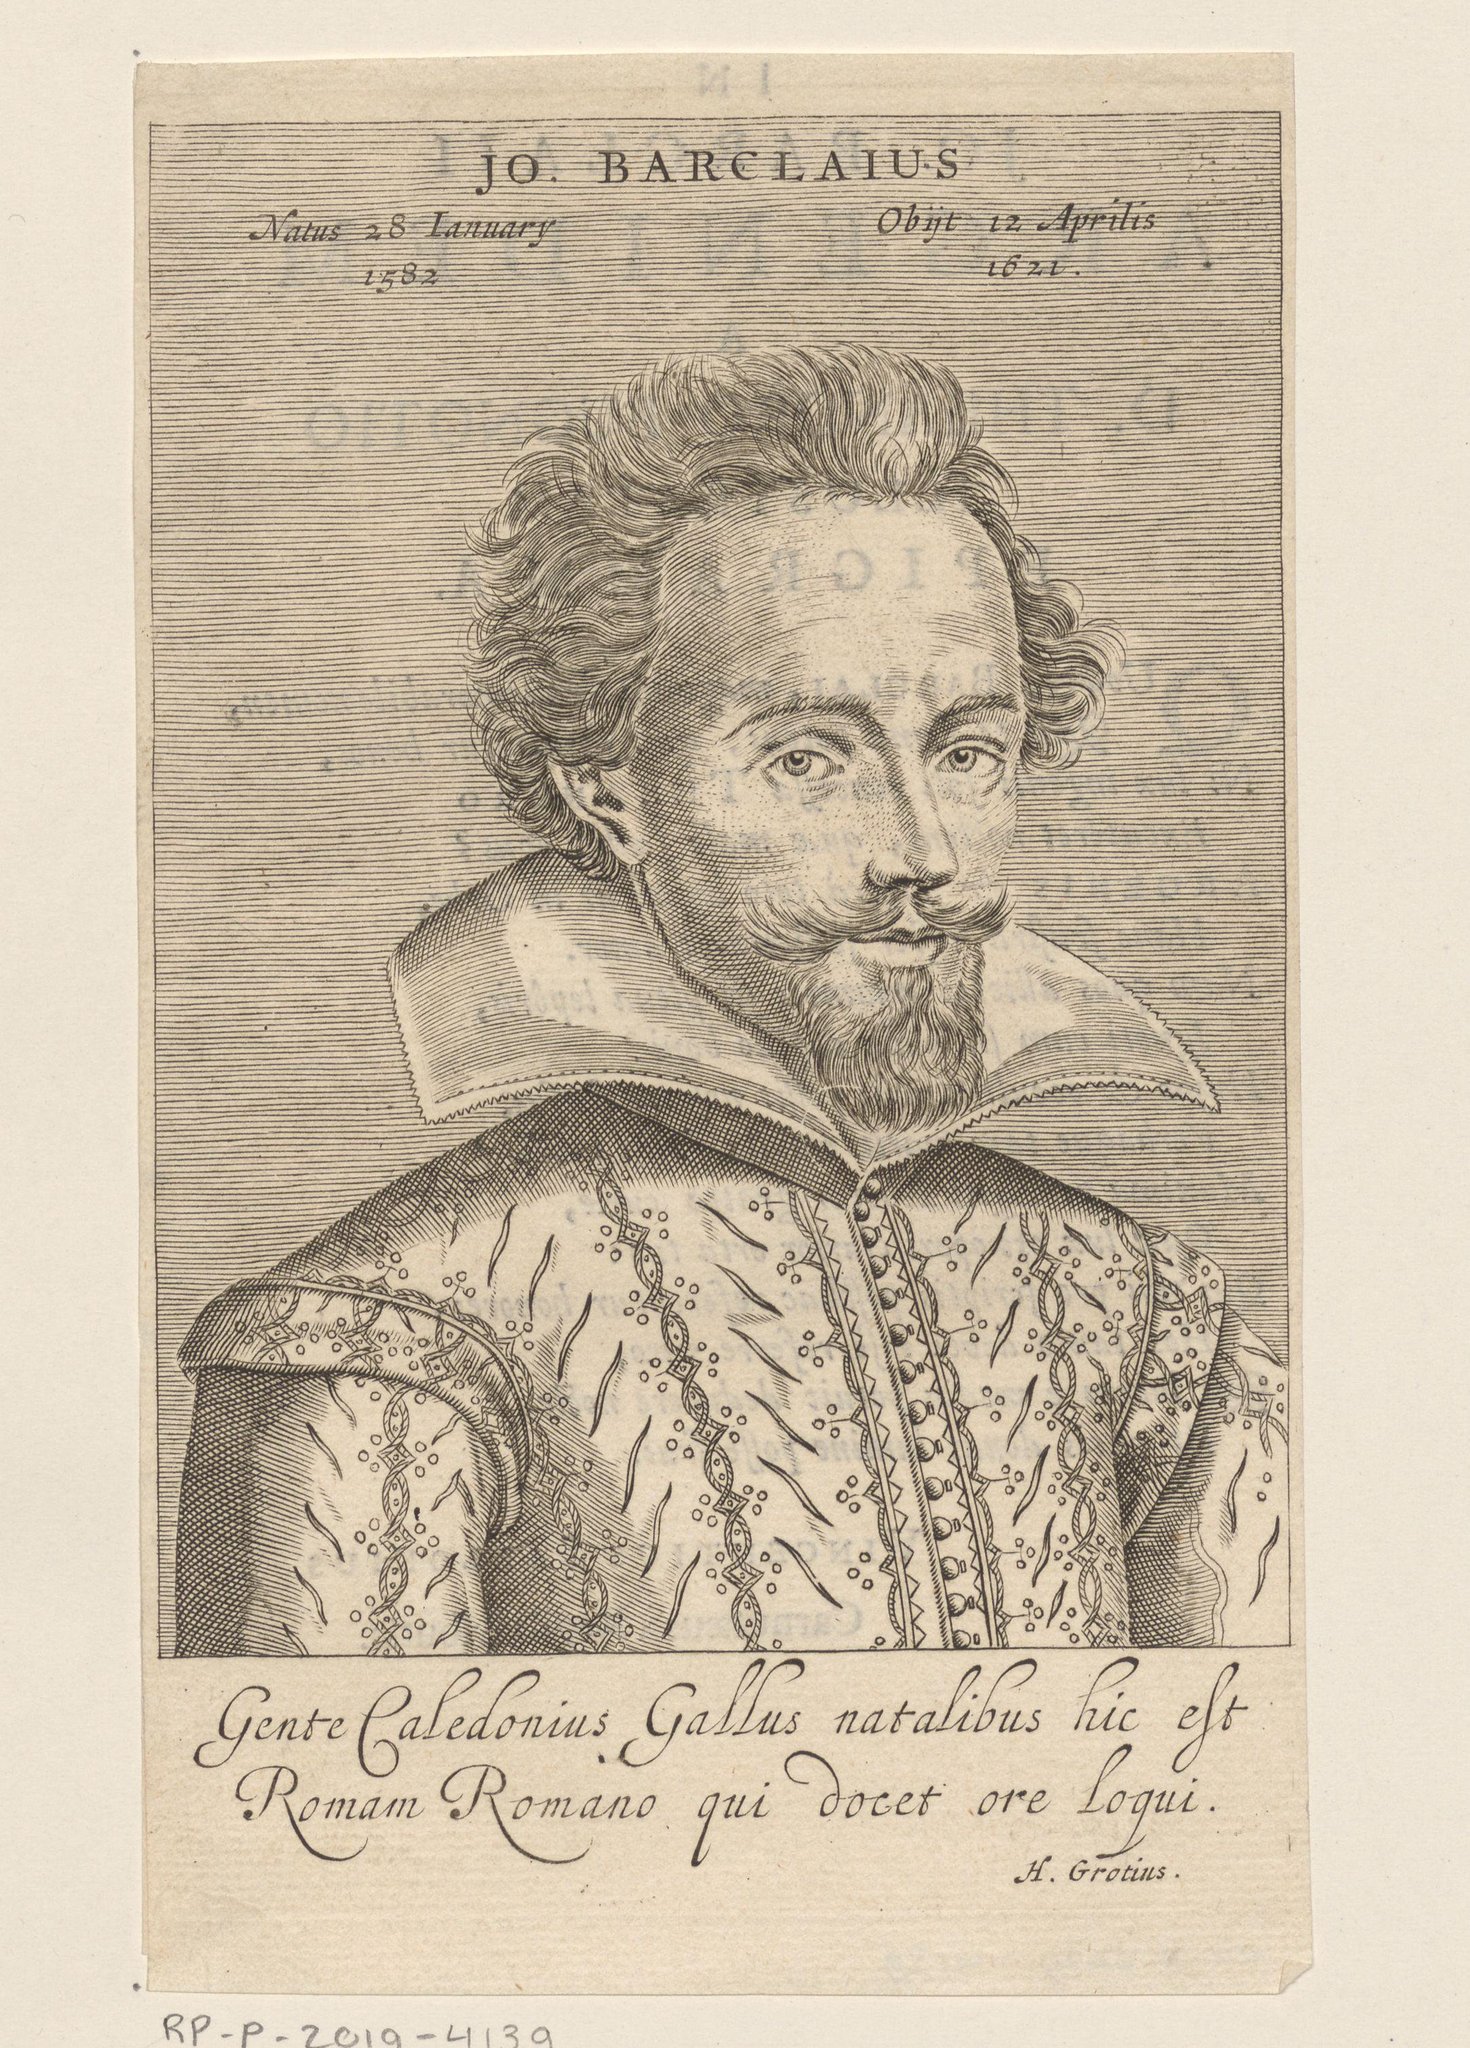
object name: print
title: Portret van John Barclay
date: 1659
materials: paper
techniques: engraving, etching, letterpress printing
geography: leiden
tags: historical persons, portrait of a writer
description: Prent uit: Barclay, John. Argenis. Leiden: Franciscus Hackius, 1659. Prent ook gebruikt in de editie van 1664.